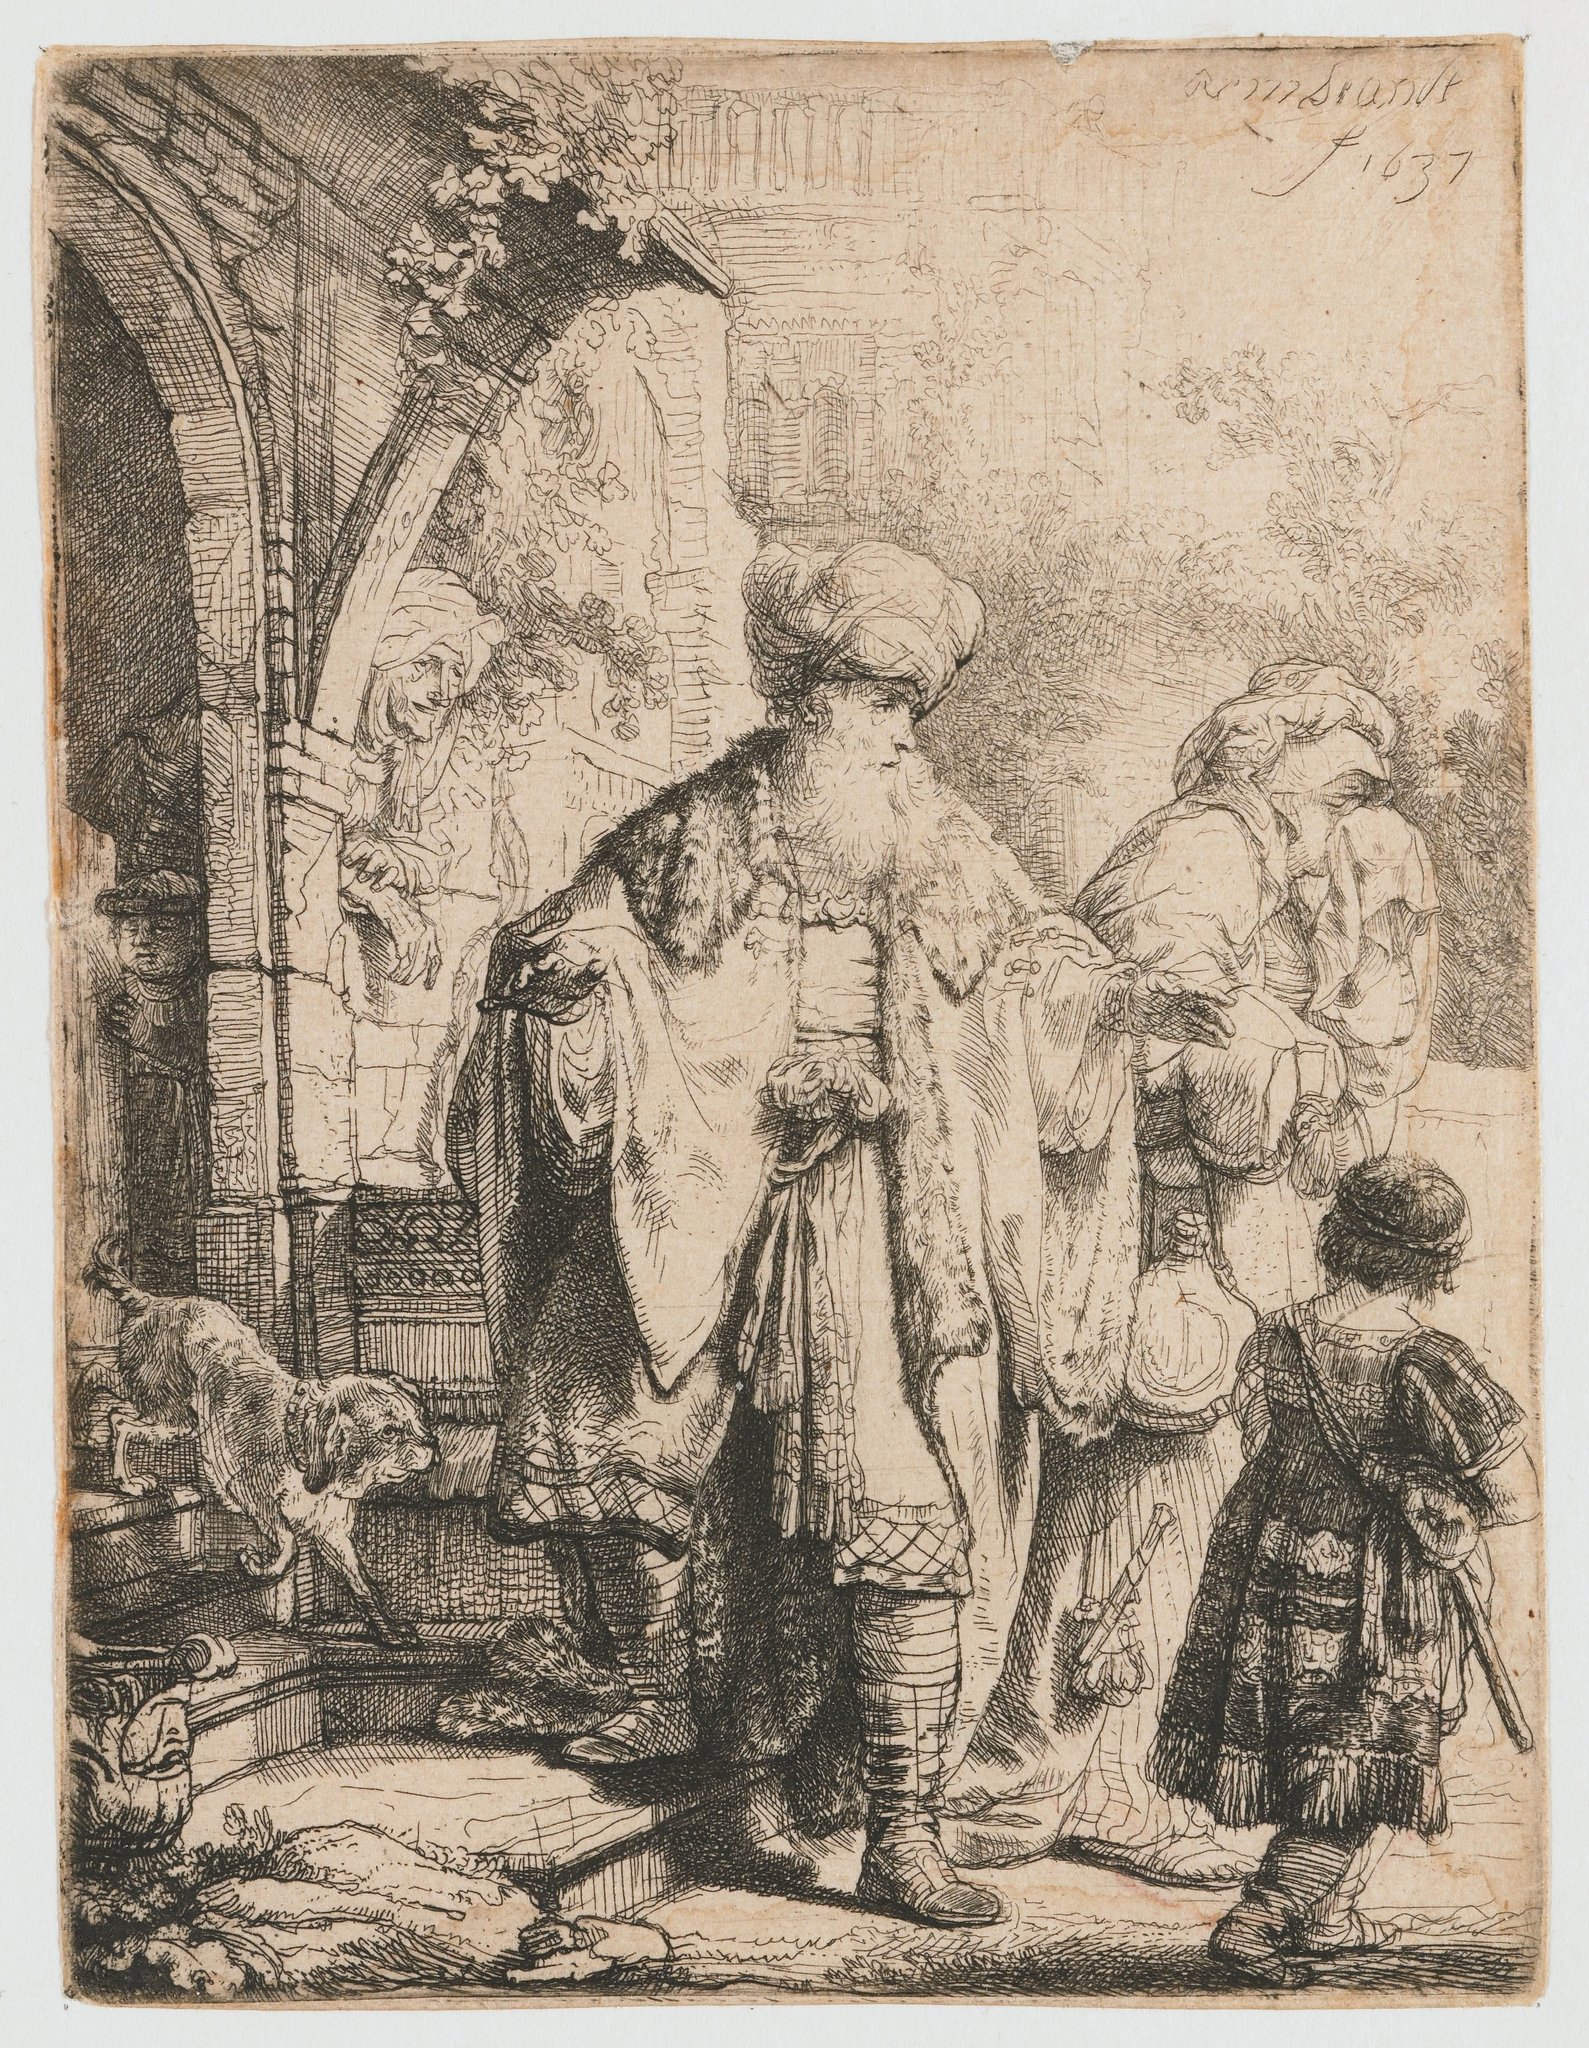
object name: print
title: Abraham casting out Hagar and Ishmael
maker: rembrandt van rijn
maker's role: draughtsman, painter, print maker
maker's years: 1606-1669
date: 1637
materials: paper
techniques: drypoint, etching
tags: the banishment of hagar and ishmael (genesis 21:9-21)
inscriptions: collector's mark: Lugt 240, signature and date: ‘Rembrandt f. 1637’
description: Before Abraham and Sarah had their own child, Isaac, at a very advanced age, Abraham had already fathered a son with Hagar, Sarah’s Egyptian servant. After Isaac’s birth, Sarah insisted that Abraham cast out Hagar and her son, Ishmael. Abraham reluctantly agreed. Rembrandt injects the scene with drama. At the right, the distraught, tearful Hagar is being sent away. At the left, Sarah leans out the window, laughing out loud.